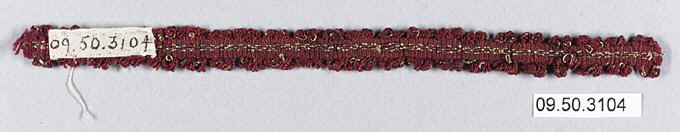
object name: gimp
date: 1801-1900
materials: metal thread, silk